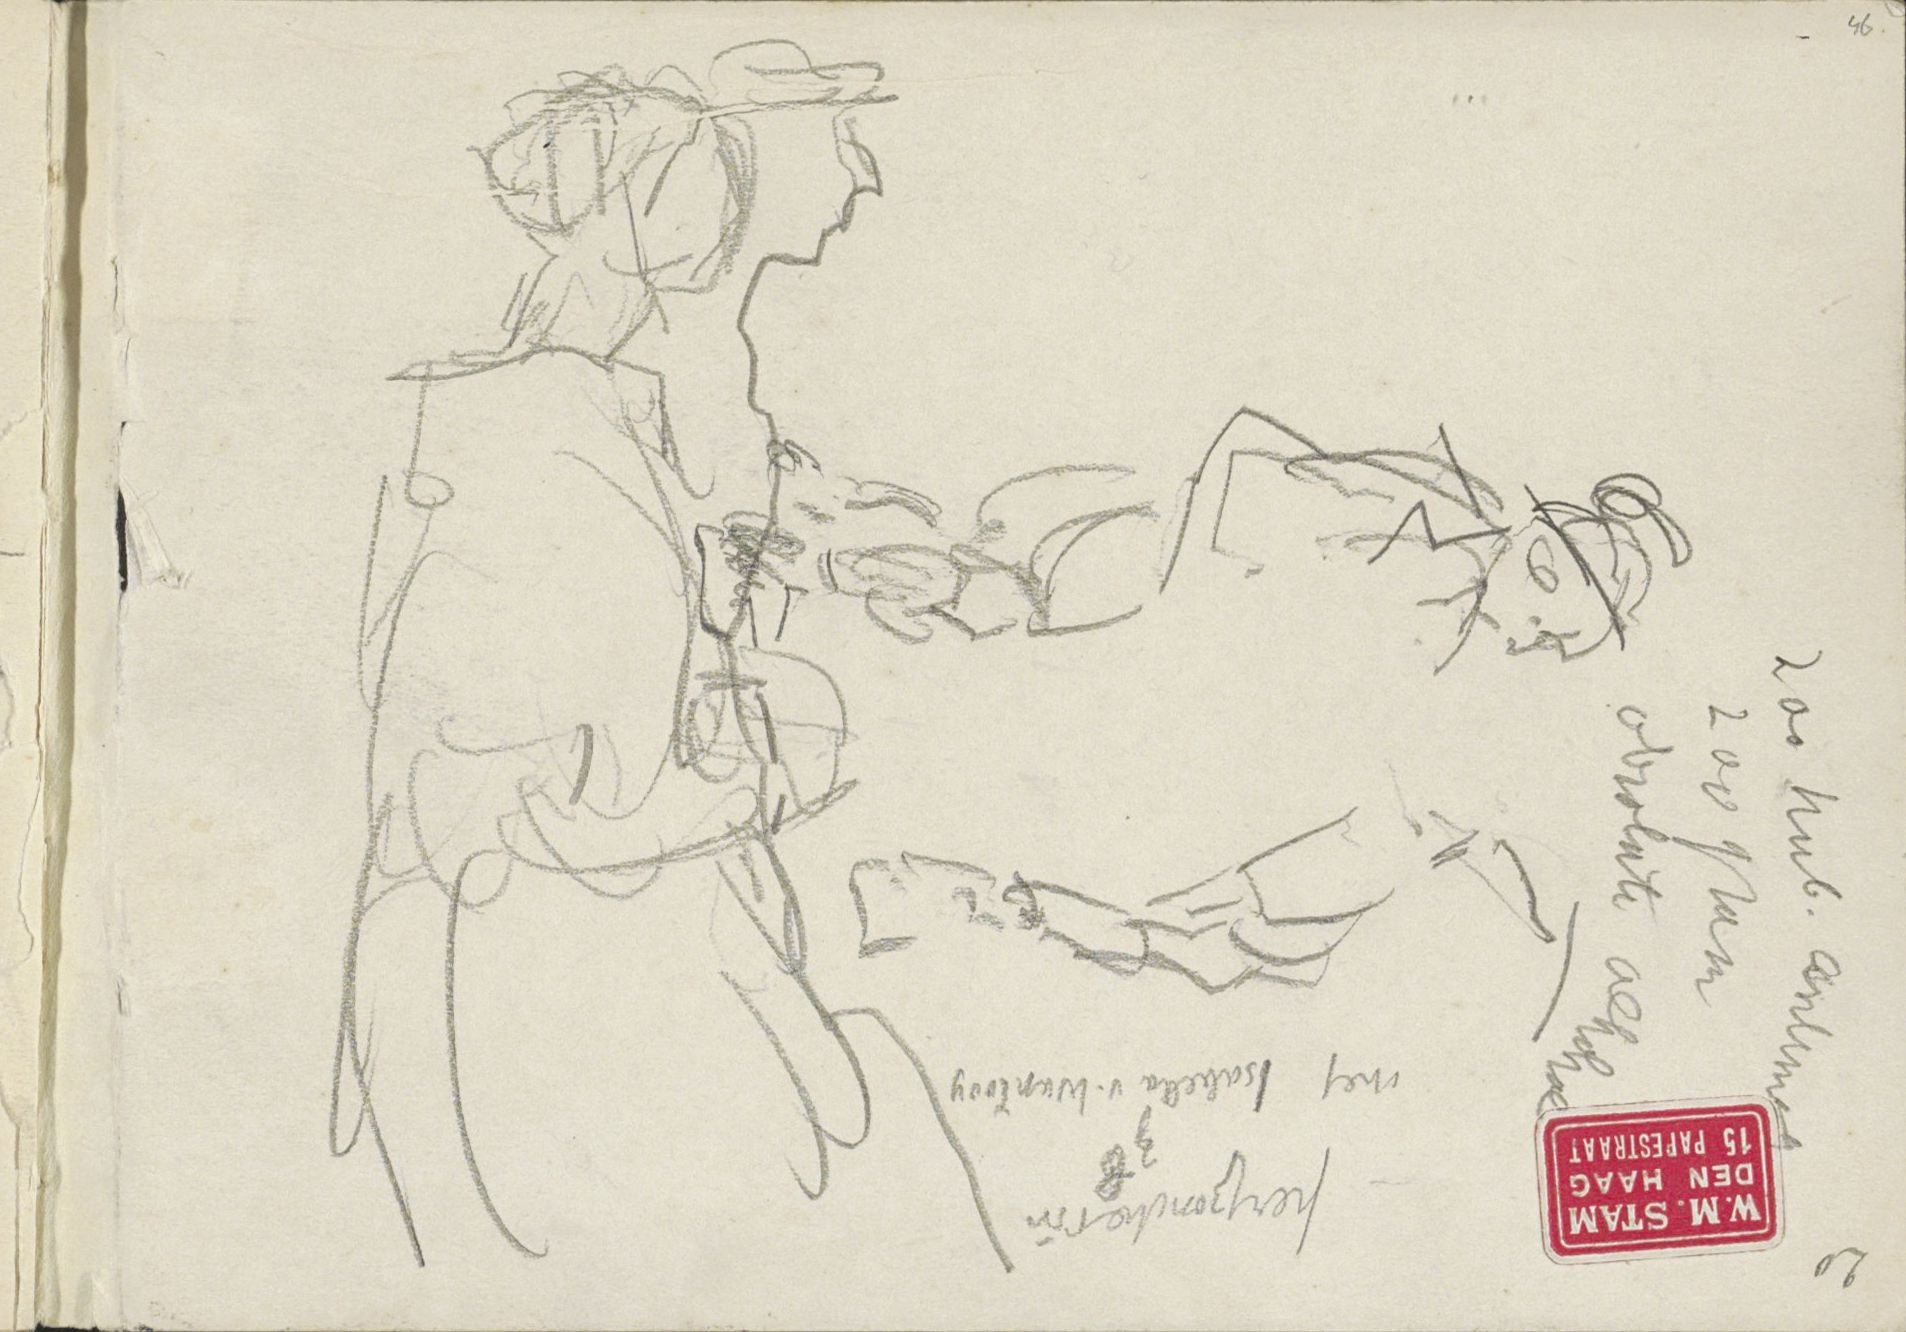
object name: sketchbook leaf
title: Figuurstudies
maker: isaac israels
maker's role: draughtsman, painter, print maker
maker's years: 1865-1934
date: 1930-1934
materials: paper, pencil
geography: the hague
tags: child (+ sideview, profile), adult man (+ sideview, profile), adult woman (+ sideview, profile)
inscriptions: retailer's mark: ‘W.M. Stam / Den Haag / 15 Papestraat’, annotation: ‘per[...]oncherin / chez[?] Isabella v. Wanrooy / 200 [...] / 200 gram / absolute alcohol’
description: Een man en een vrouw, in profiel, en twee studies van een kind, eveneens in profiel. Pagina 46, achterste schutblad, uit schetsboek XXXVIII met 45 pagina's.